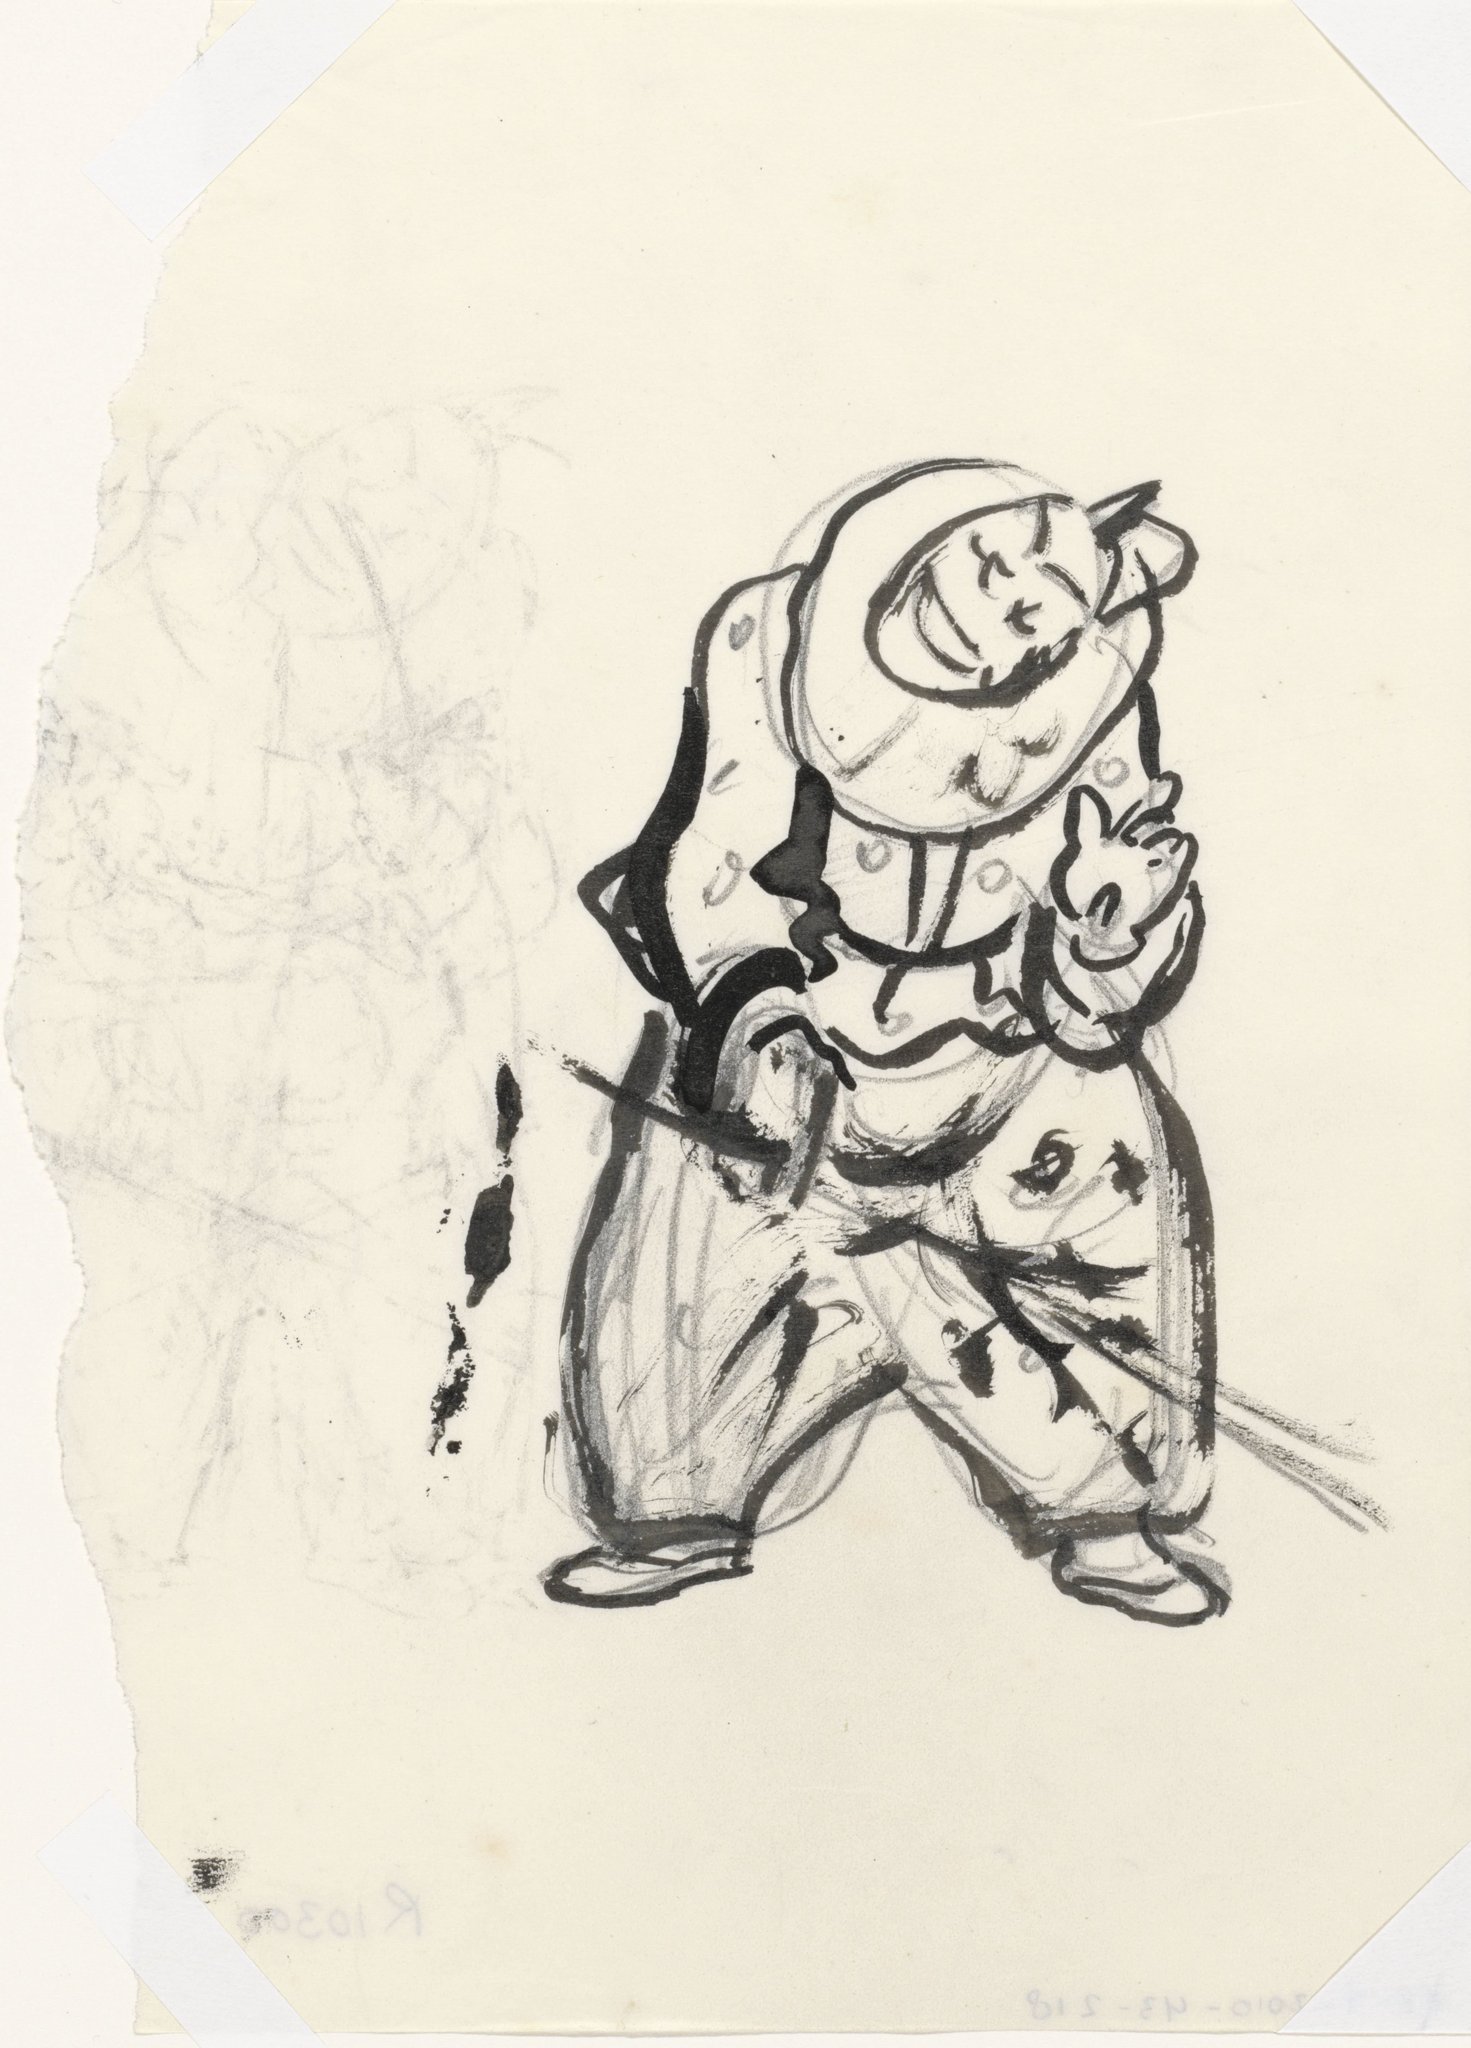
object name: drawing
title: Zonder titel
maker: leo gestel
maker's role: draughtsman, print maker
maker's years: 1881-1941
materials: ink, paper, pencil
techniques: brush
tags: types in 'commedia dell'arte': pierrot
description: Pierrot met gesloten ogen en zweep in het midden.